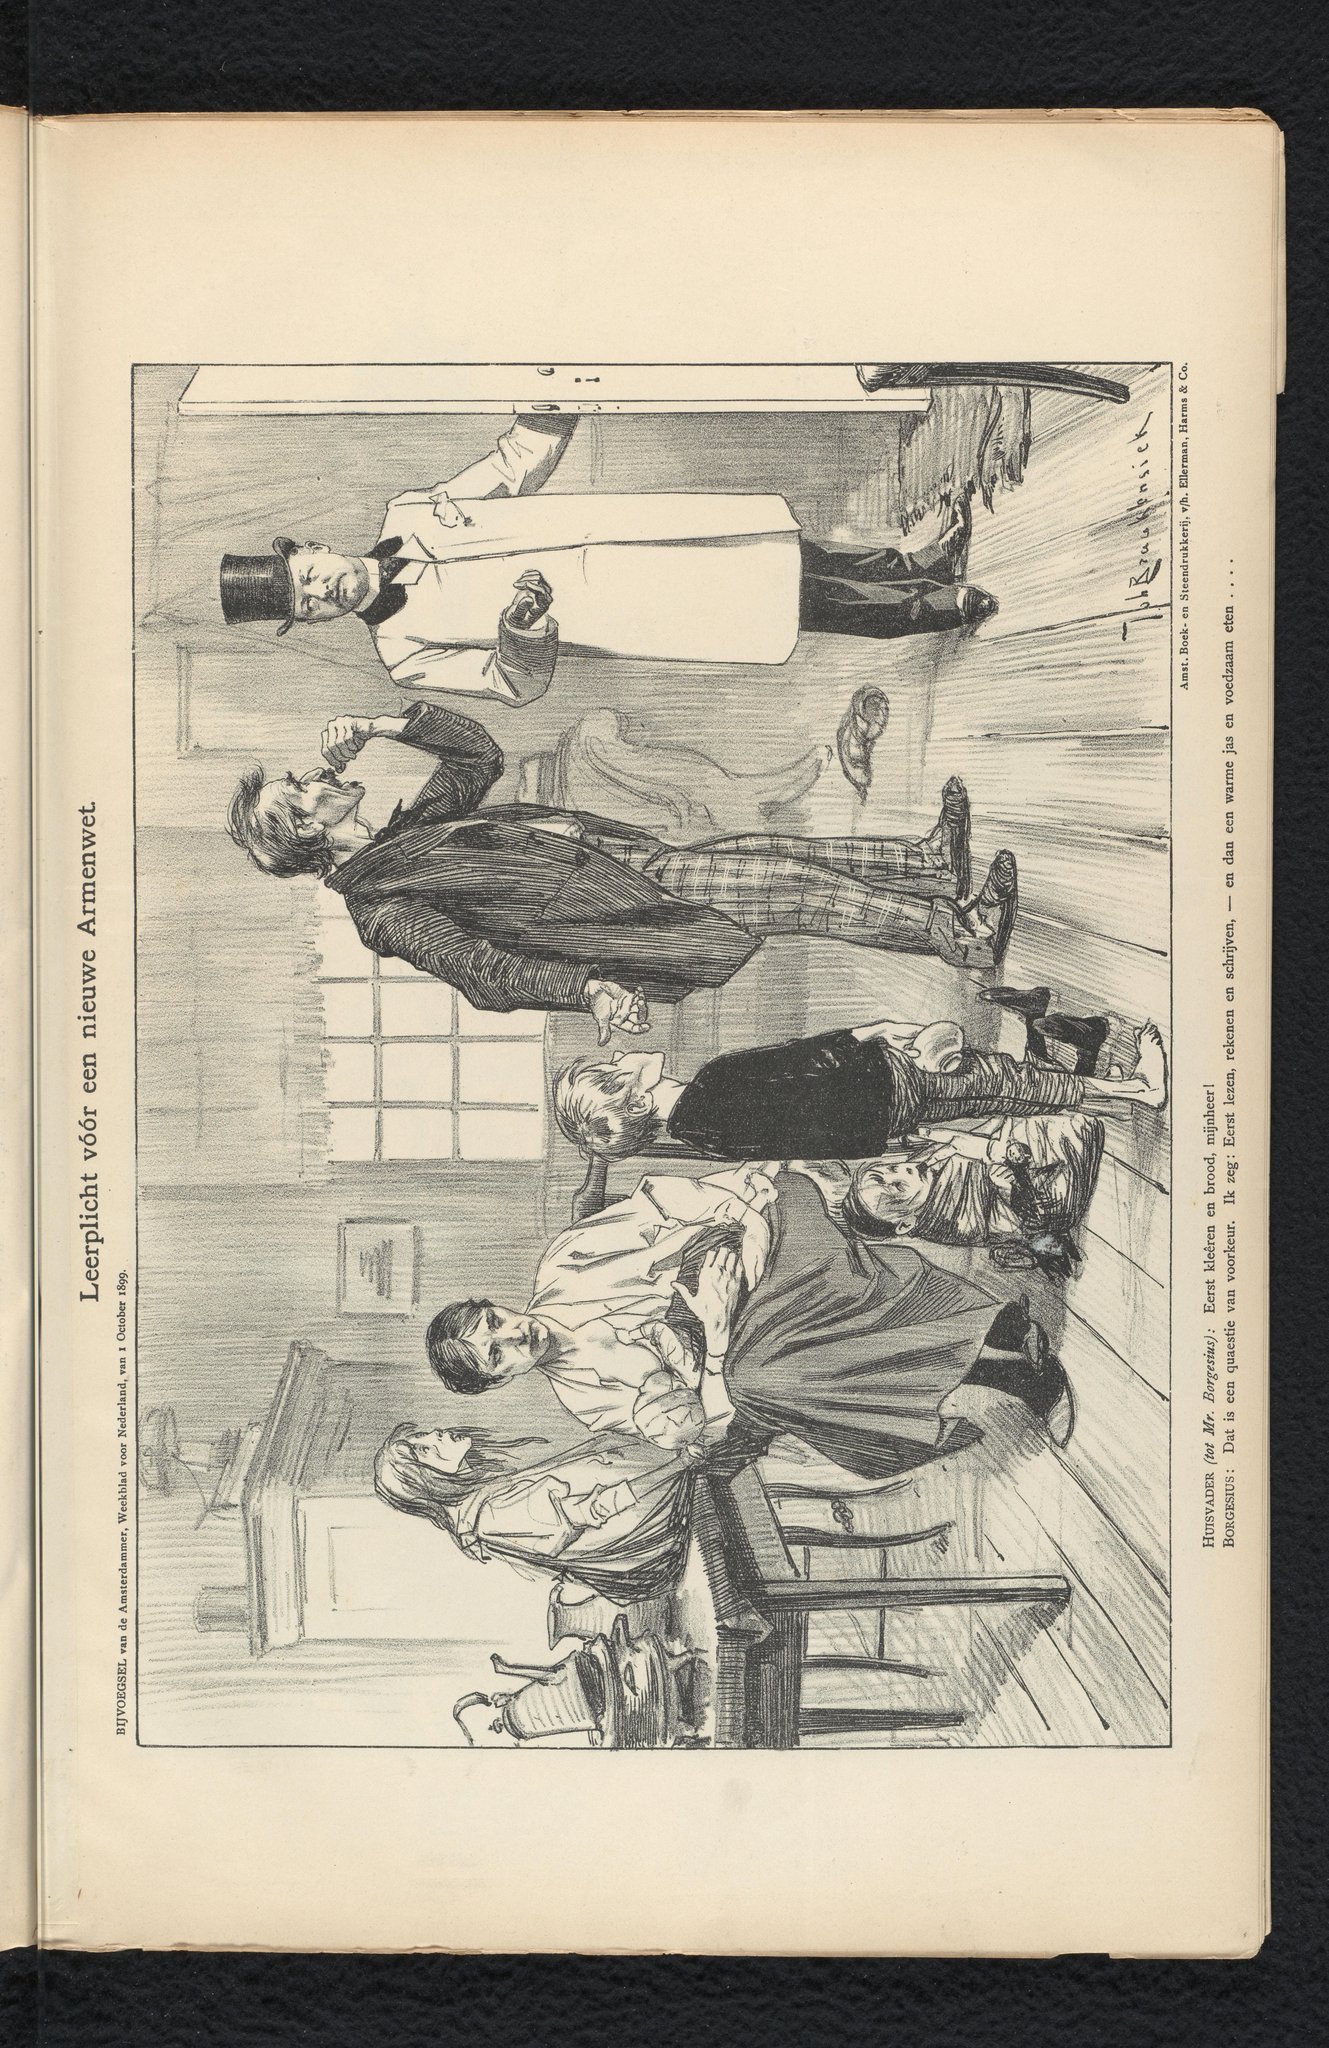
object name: cartoon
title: Leerplicht vóór een nieuwe Armenwet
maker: johan braakensiek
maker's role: draughtsman, print maker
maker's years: 1858-1940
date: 1899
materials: paper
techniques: lithograph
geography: amsterdam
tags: the hague, politician, the poor, political caricatures and satires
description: Minister van Binnenlandse Zaken Borgesius laat een arm gezin weten dat leerplicht vóór eten en drinken gaat.